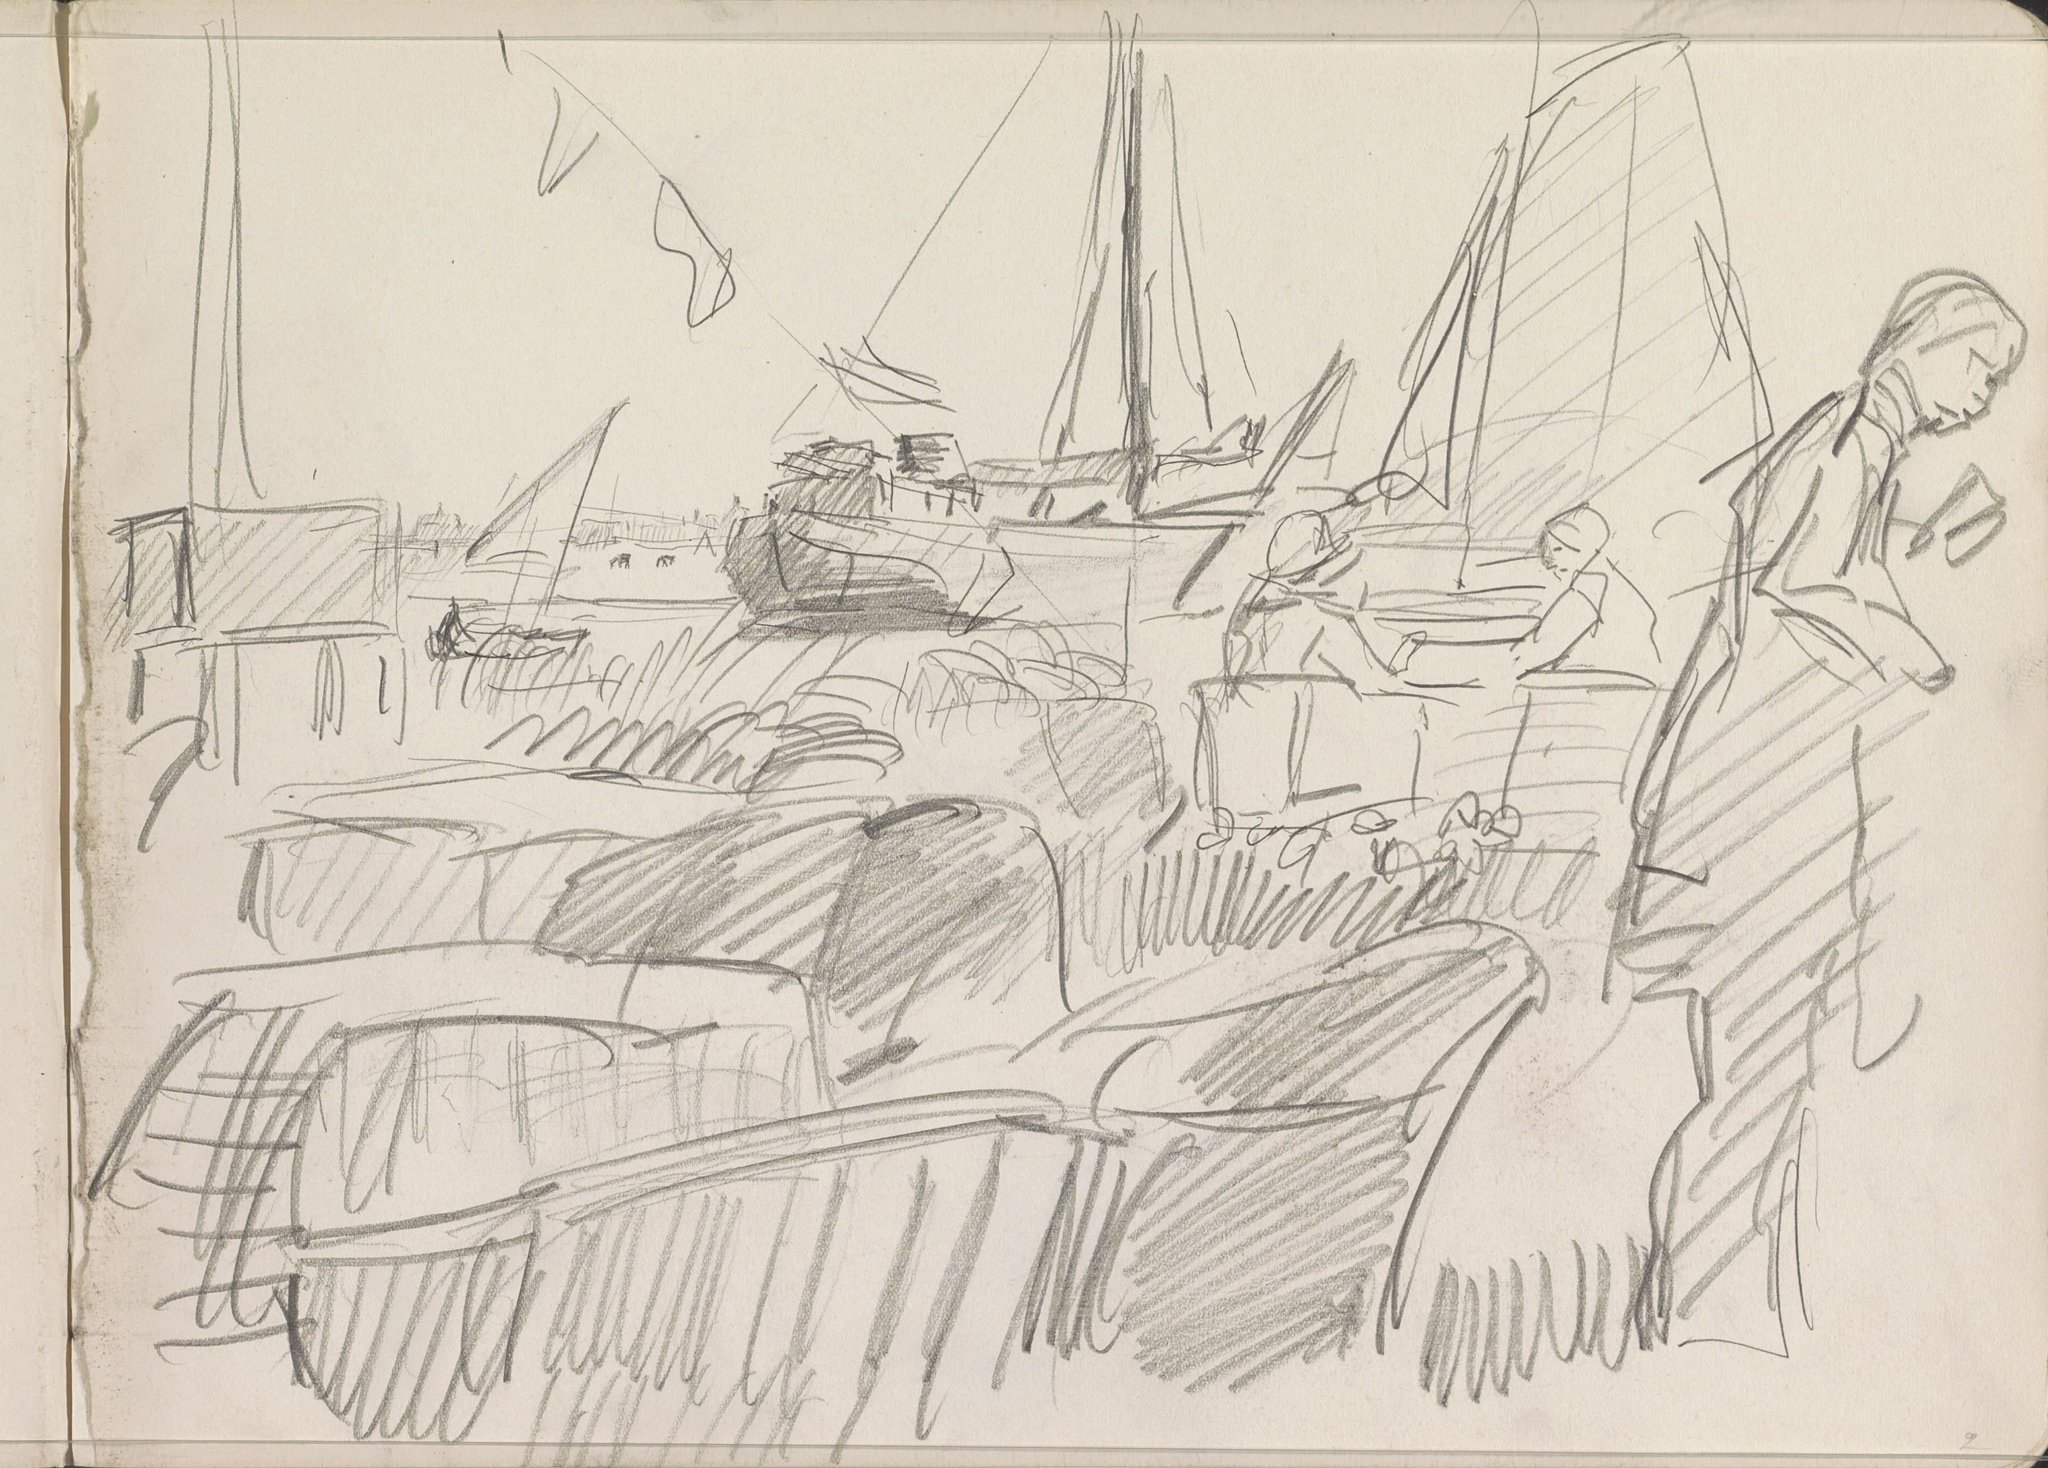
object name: sketchbook leaf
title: Café op een kade, mogelijk te Voorburg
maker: isaac israels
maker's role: draughtsman, painter, print maker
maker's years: 1865-1934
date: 1875-1934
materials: paper, pencil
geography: voorburg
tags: ships (in general), pavement, terrace in front of inn or restaurant, quay (+ city(-scape) with figures, staffage), voorburg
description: Op de achtergrond schepen. Blad 2 recto uit schetsboek II met 23 bladen.